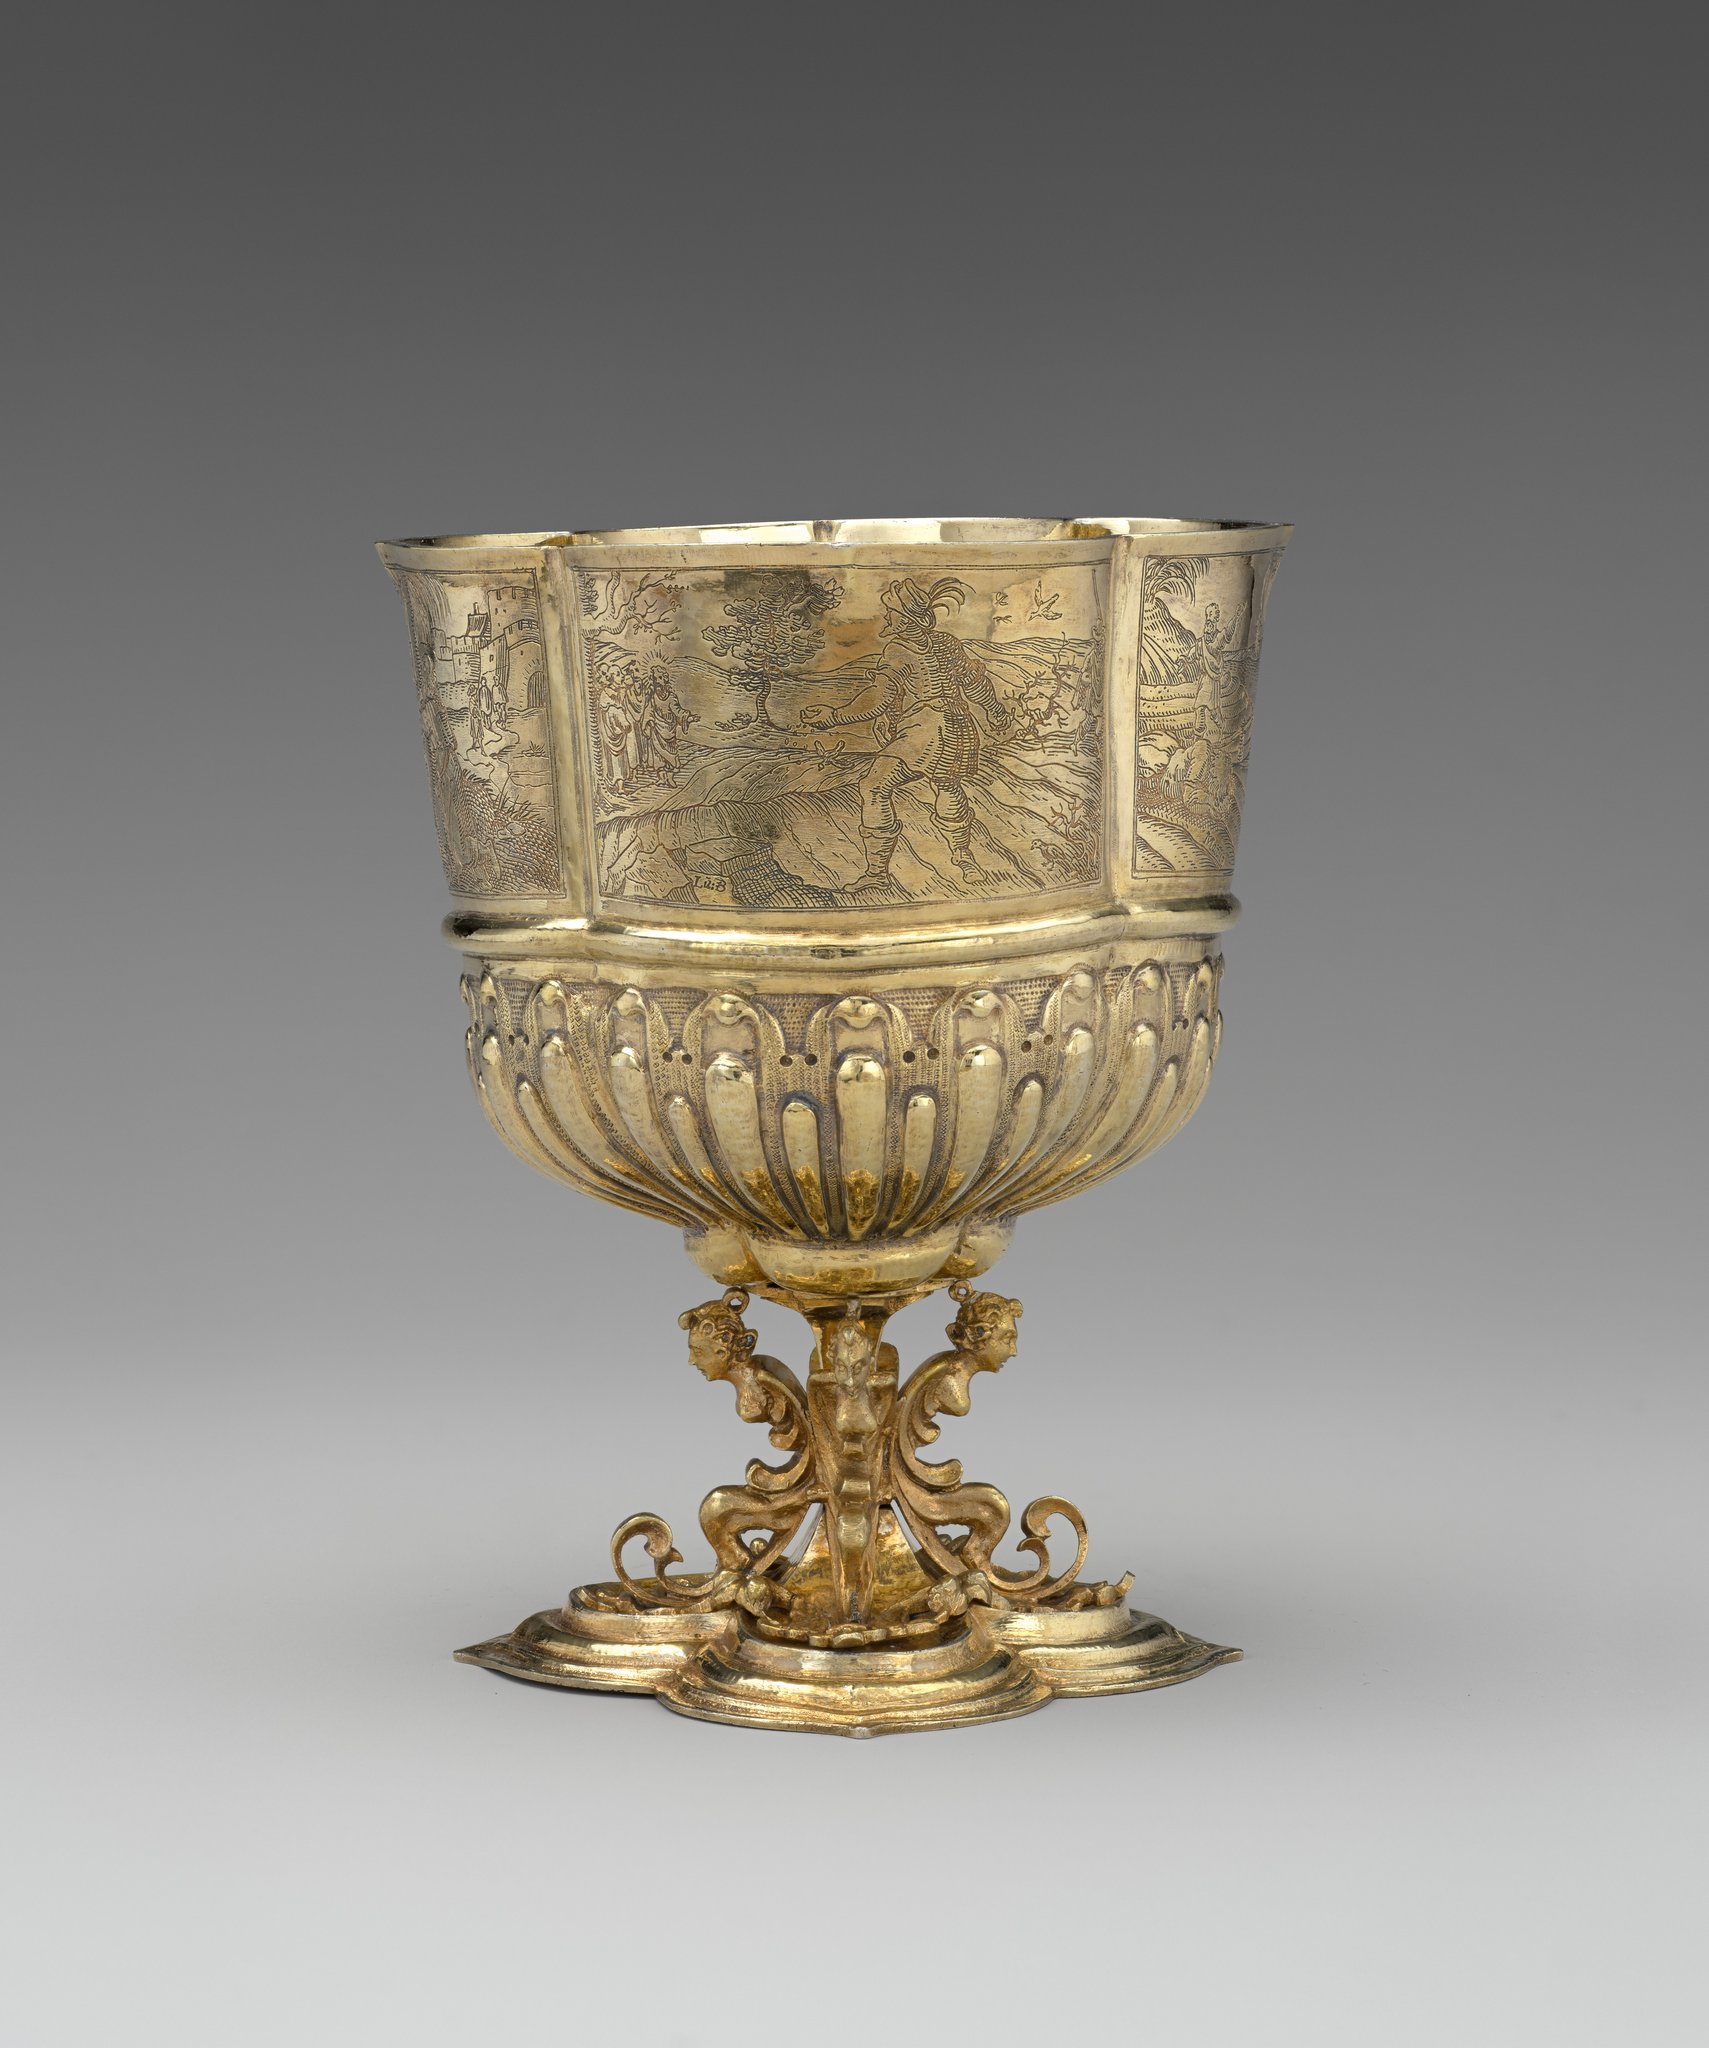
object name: cup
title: Cup with scenes from the New Testament (one of a pair)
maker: franz fischer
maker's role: maker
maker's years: 1553-1653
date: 1601-1633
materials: silver gilt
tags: men,horses